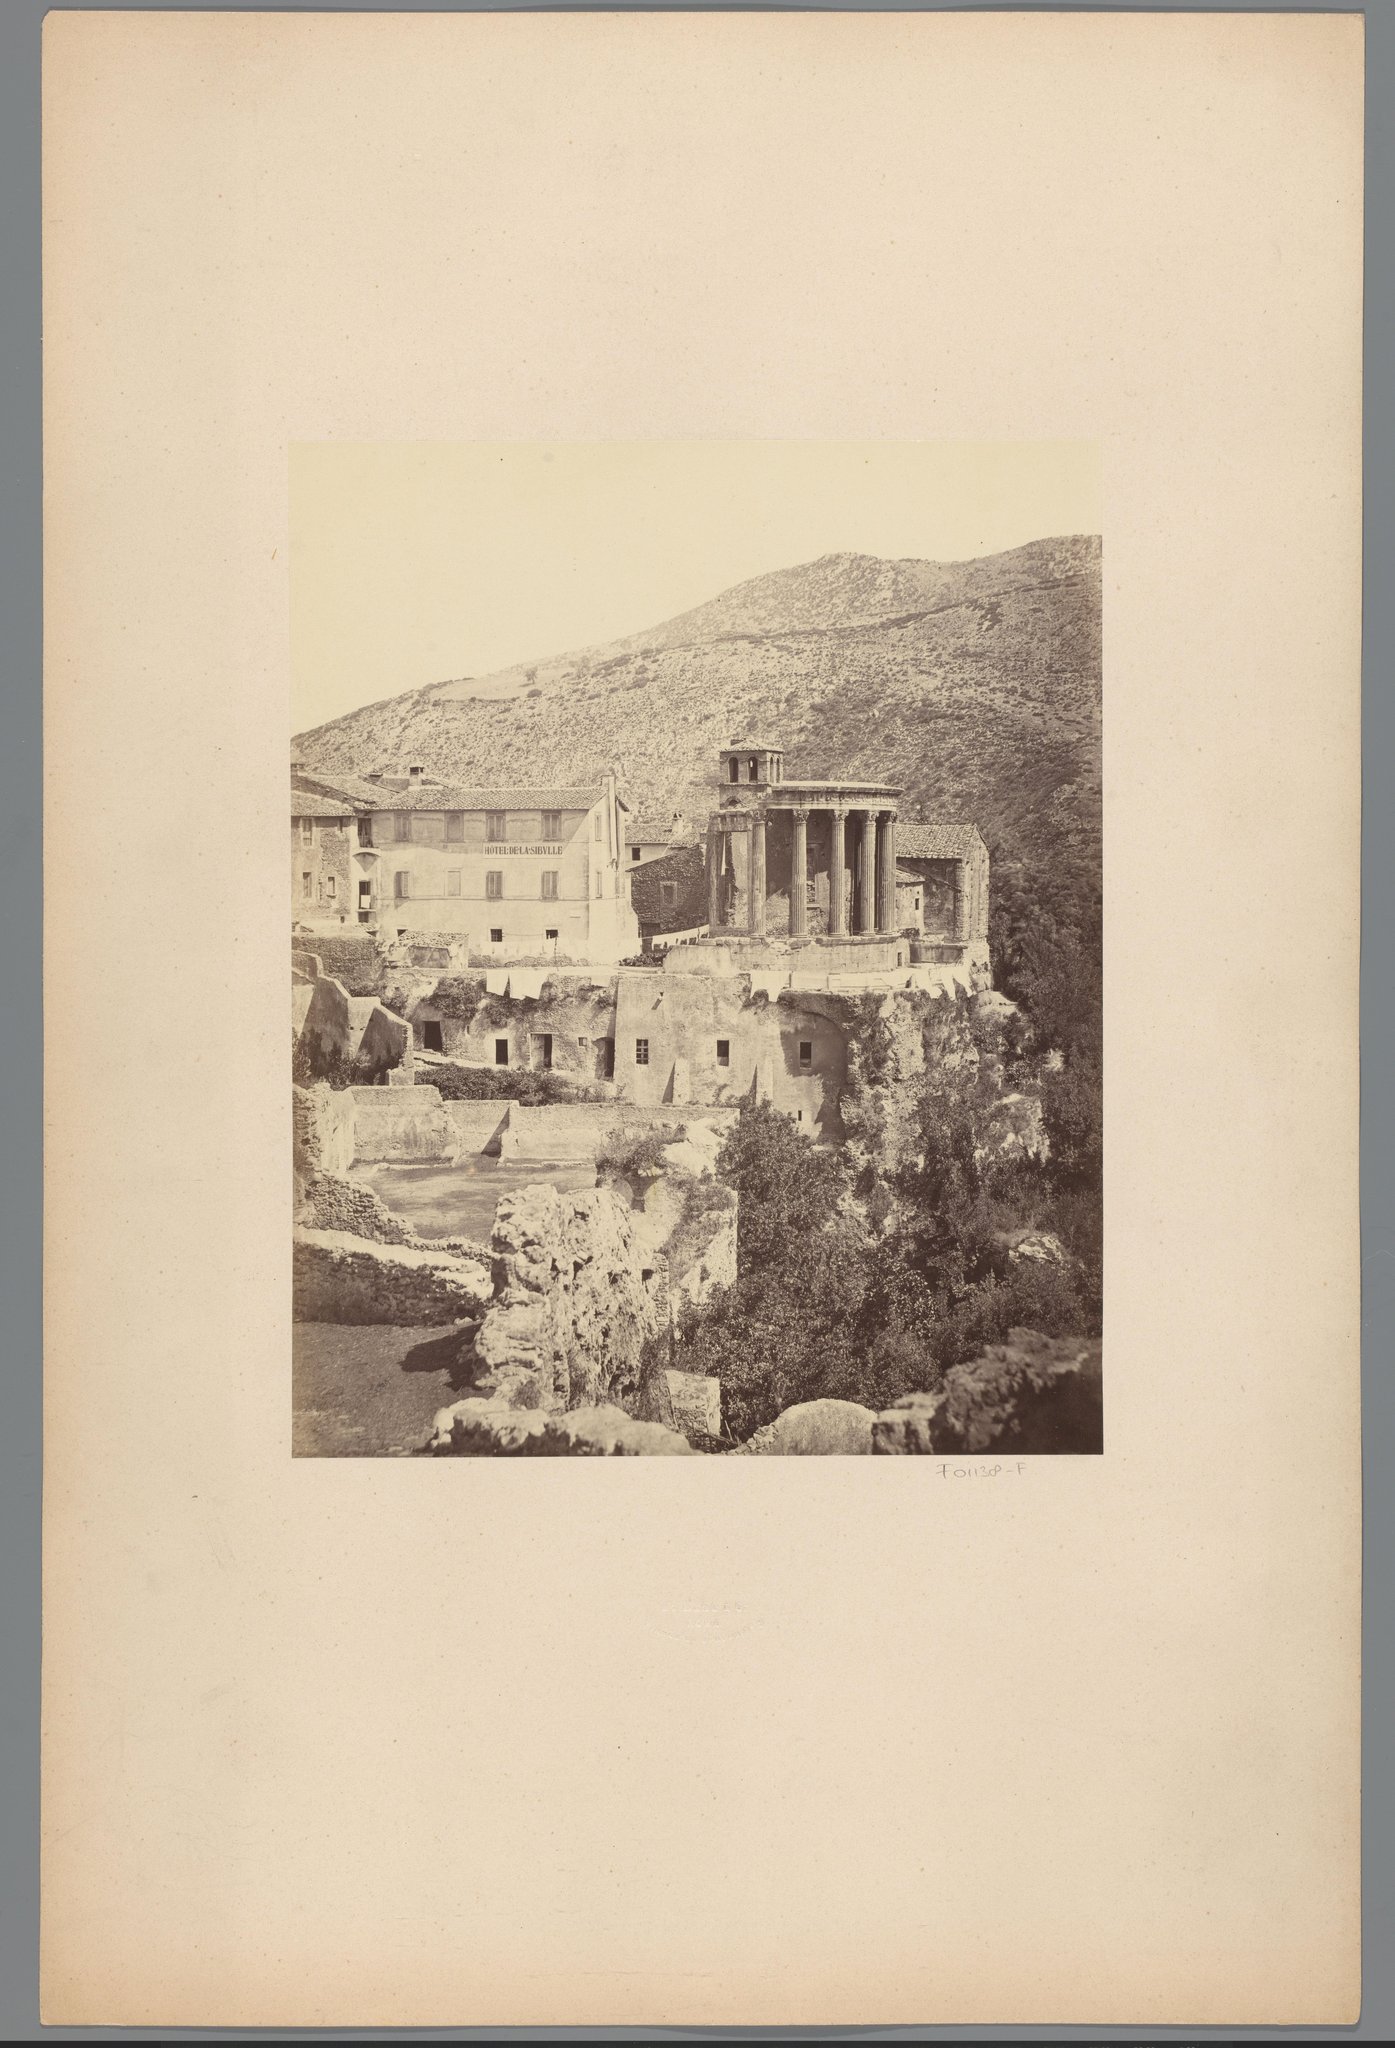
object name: photograph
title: Tempel van Vesta in Tivoli met daarnaast Hotel de la Sibylle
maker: michèle mang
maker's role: fotograaf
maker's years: 1840-1909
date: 1860-1880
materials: cardboard, photographic support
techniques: albumen print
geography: tivoli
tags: temple, shrine ~ roman religion, hotel, hostelry, inn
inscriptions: name: ‘M: Mang e C: Roma Piazza di Spagna No. 9’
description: Onderdeel van Reisalbum met opnames van kunstwerken en bezienswaardigheden in Italië, Griekenland en Frankrijk.